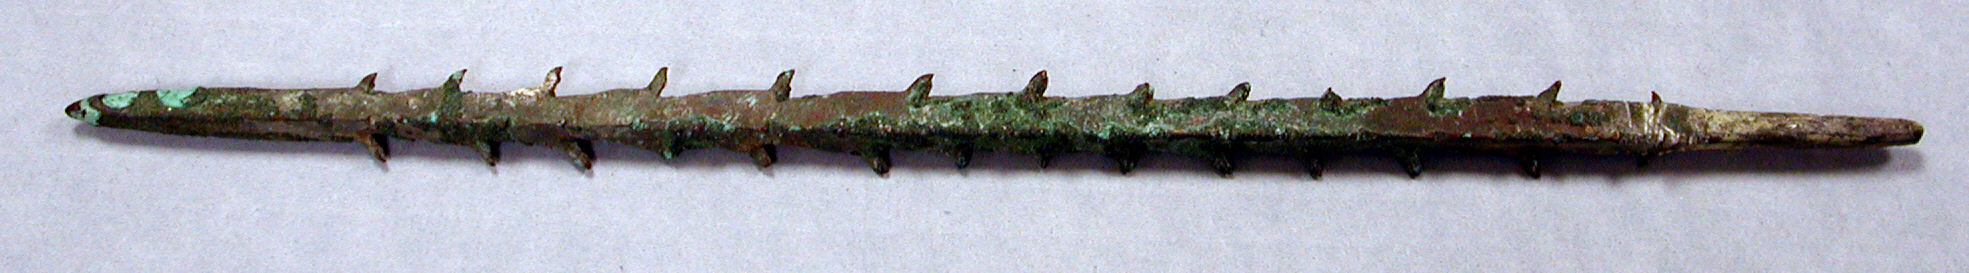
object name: point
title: Barbed Point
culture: vicús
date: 300 BCE-200 CE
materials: copper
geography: peru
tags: weapons